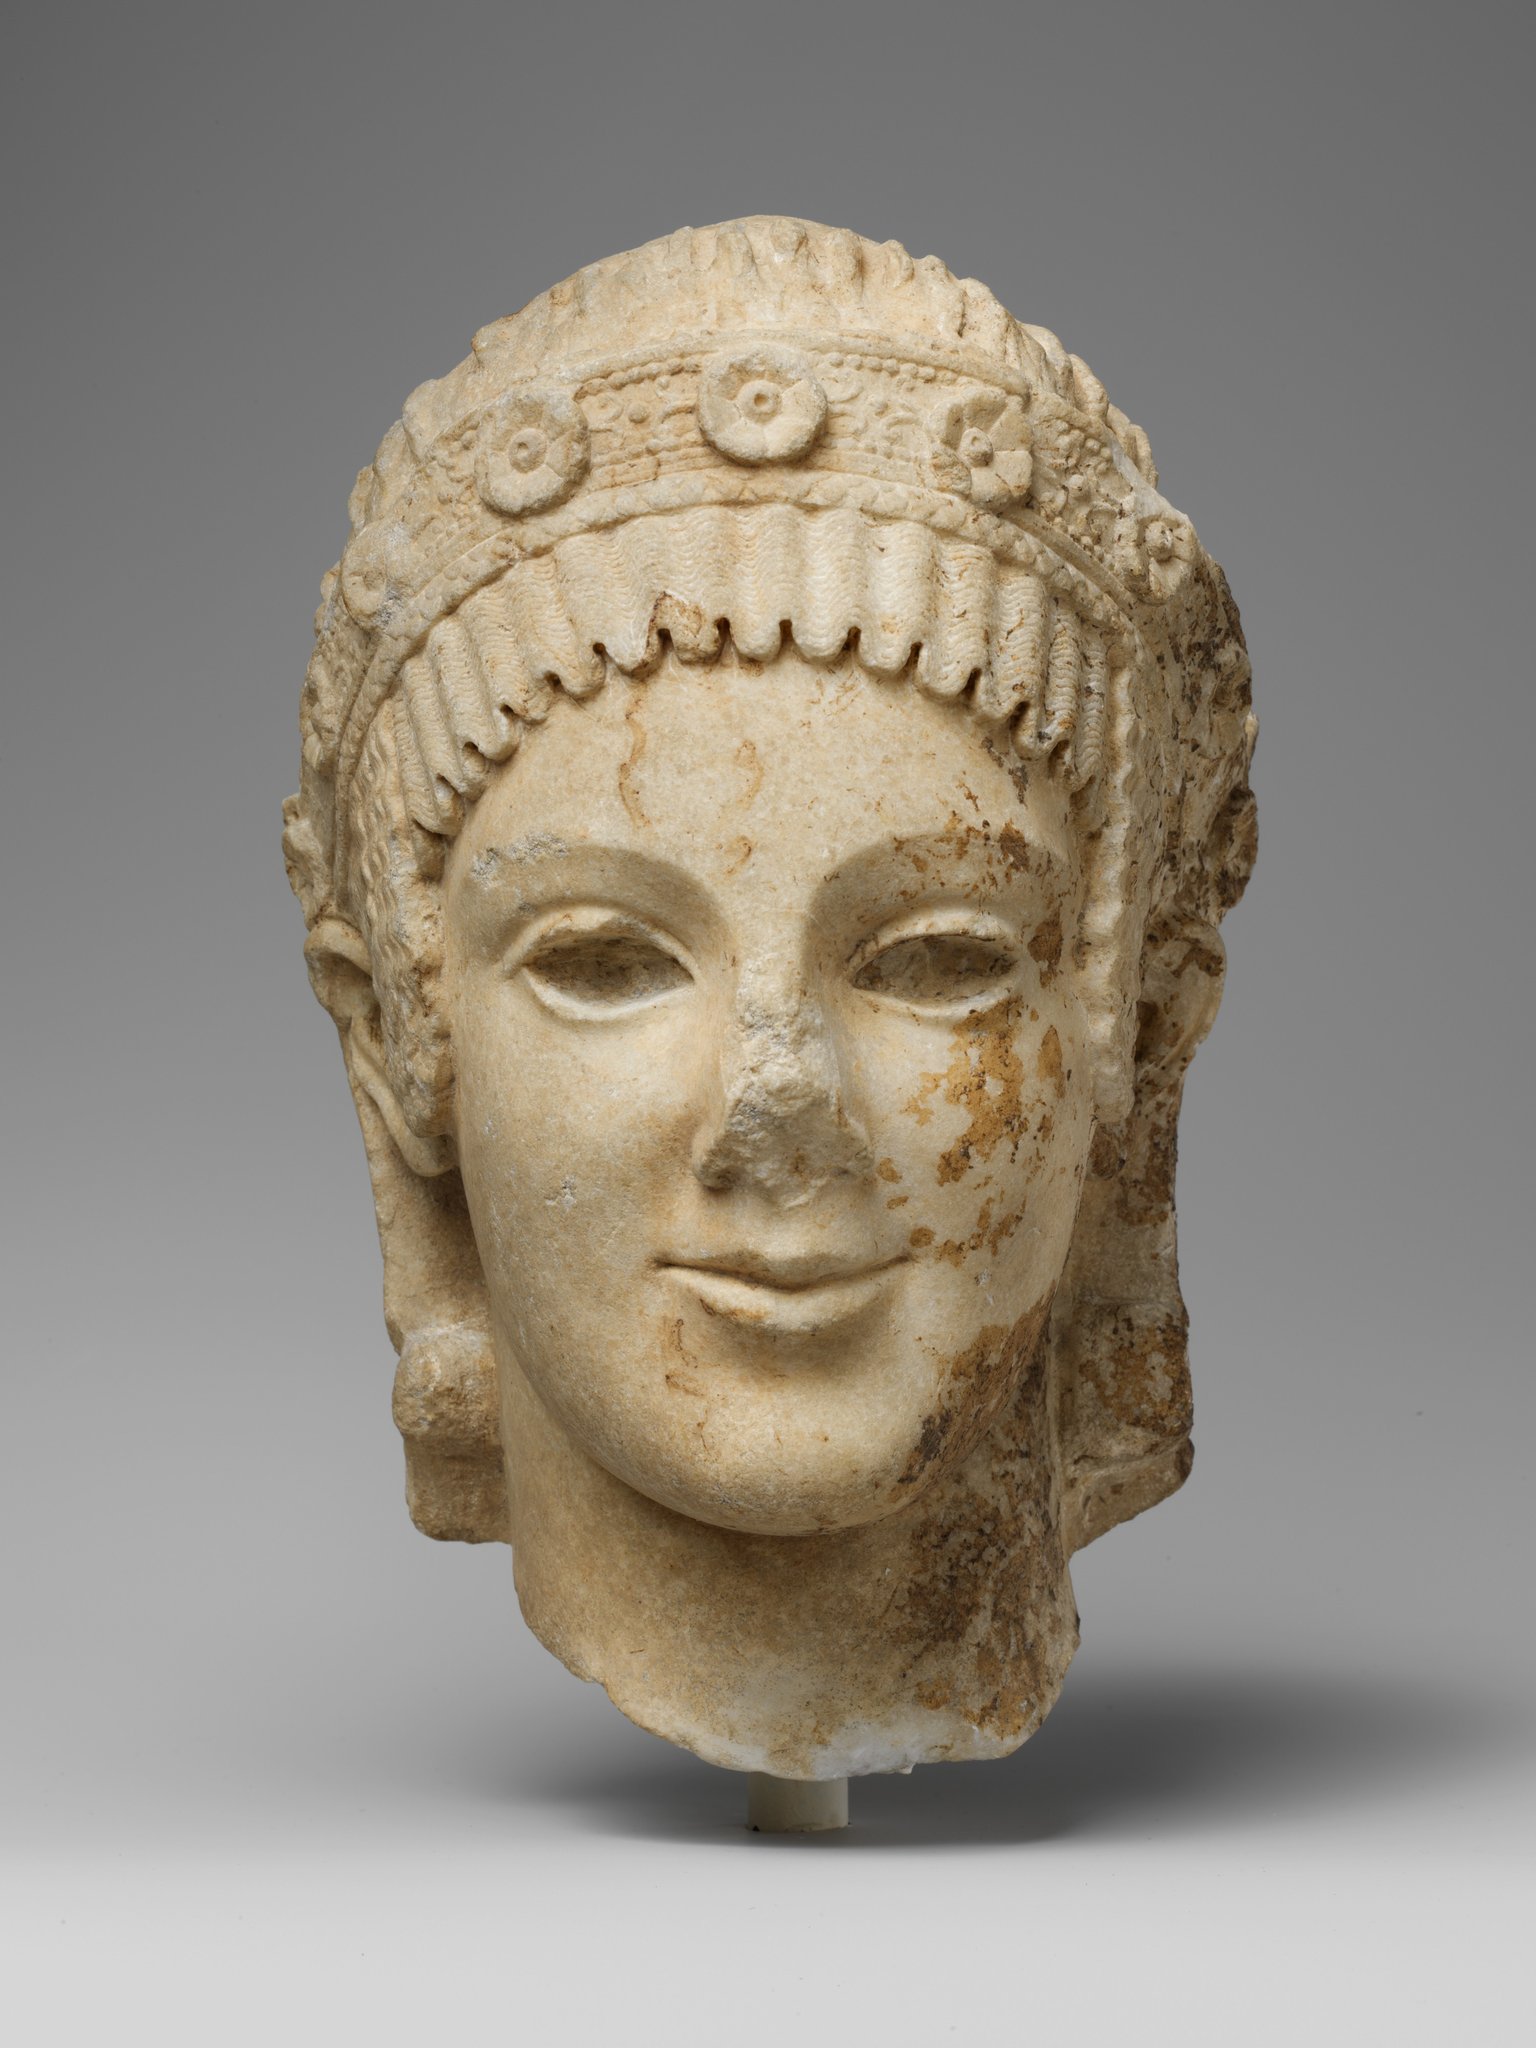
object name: head of athena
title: Marble head of Athena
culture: roman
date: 27 BCE-68 CE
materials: marble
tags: heads,athena,goddess